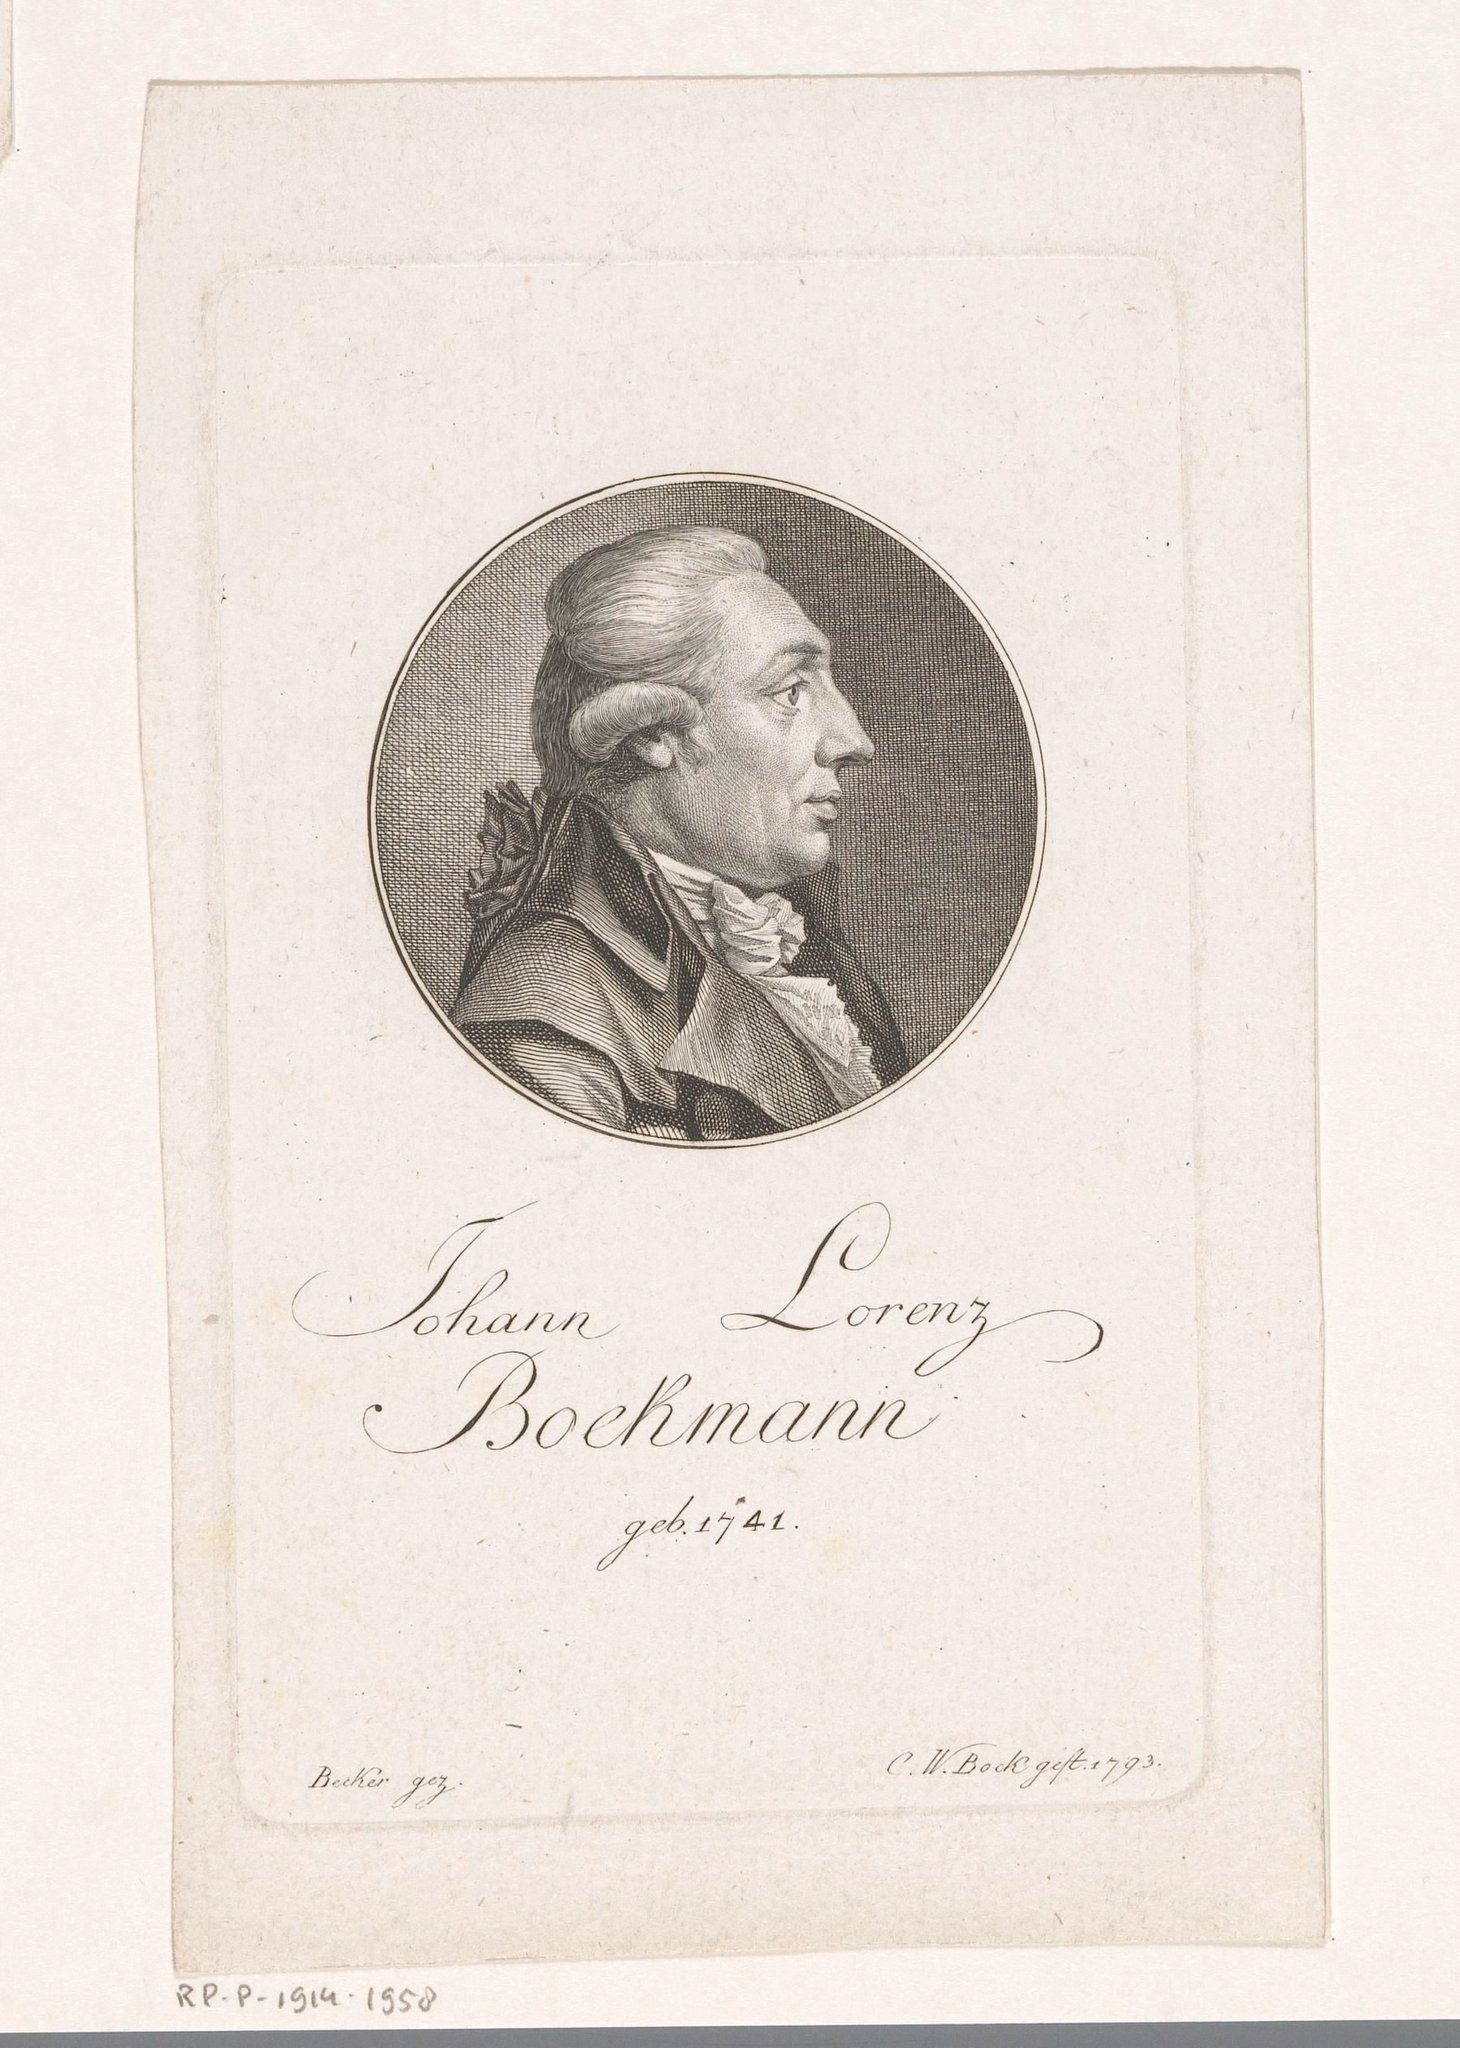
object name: print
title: Portret van Johann Lorenz Böckmann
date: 1793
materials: paper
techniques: engraving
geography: nuremberg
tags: historical persons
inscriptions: collector's mark: Lugt 2228